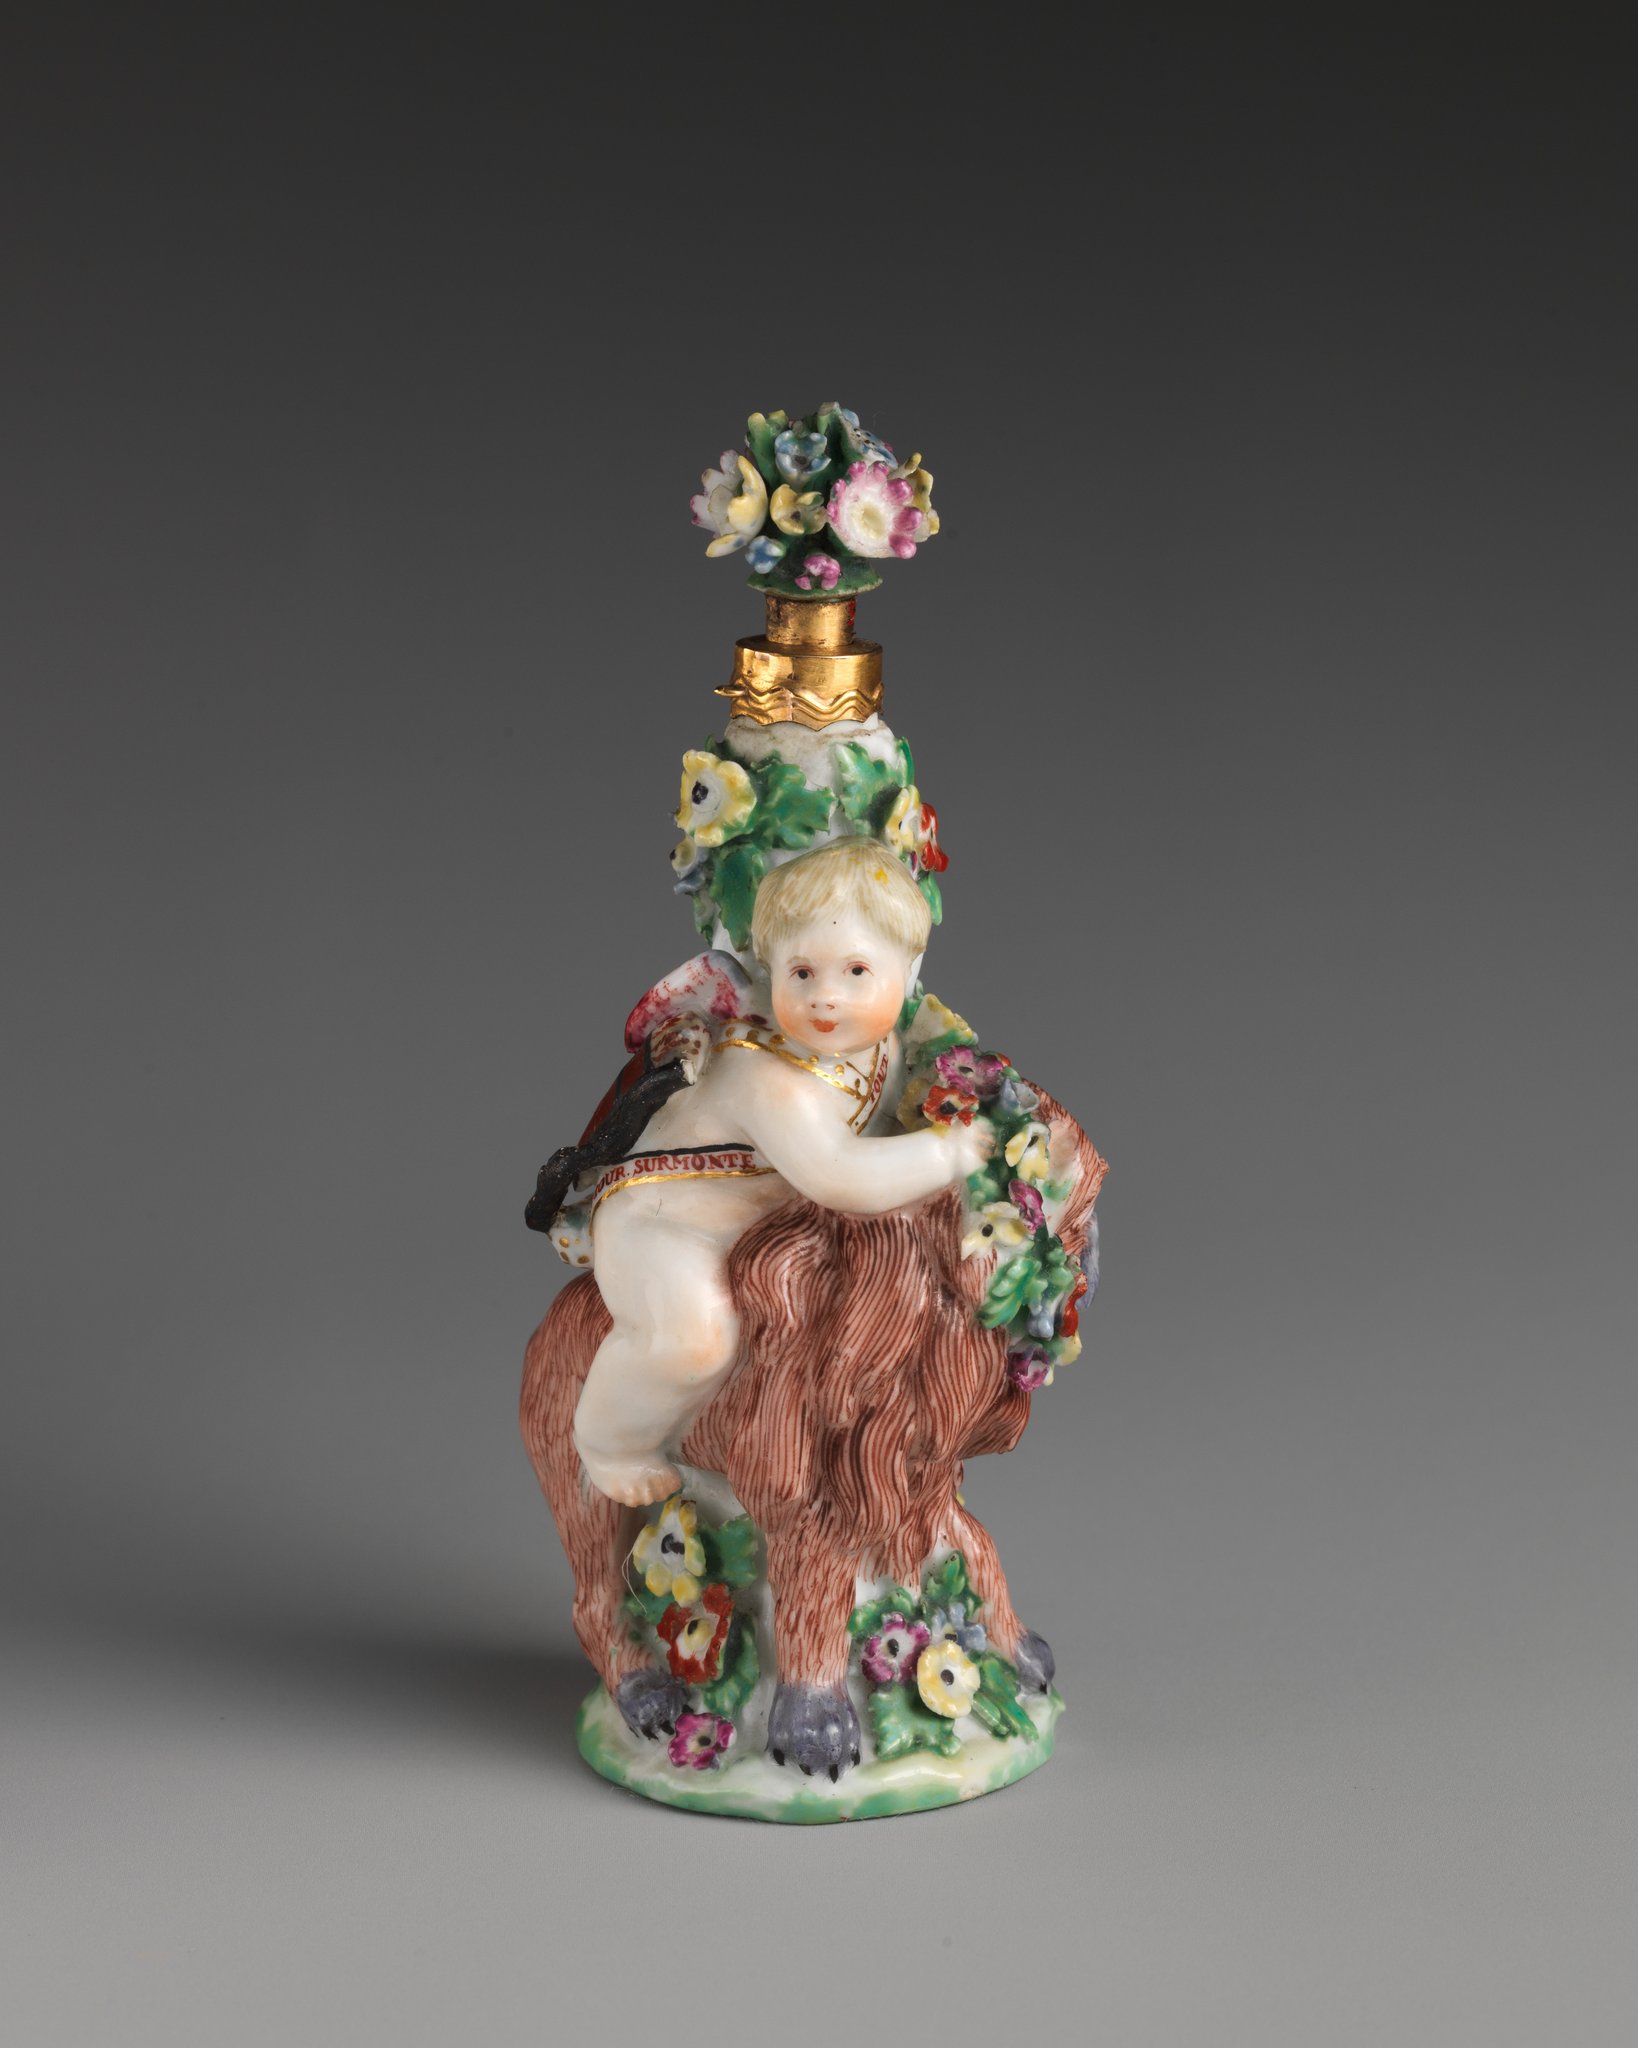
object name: toy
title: Cupid on a lion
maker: chelsea porcelain manufactory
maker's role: factory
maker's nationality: british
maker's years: 1744-1784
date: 1765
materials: soft paste porcelain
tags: cupid,lions,flowers